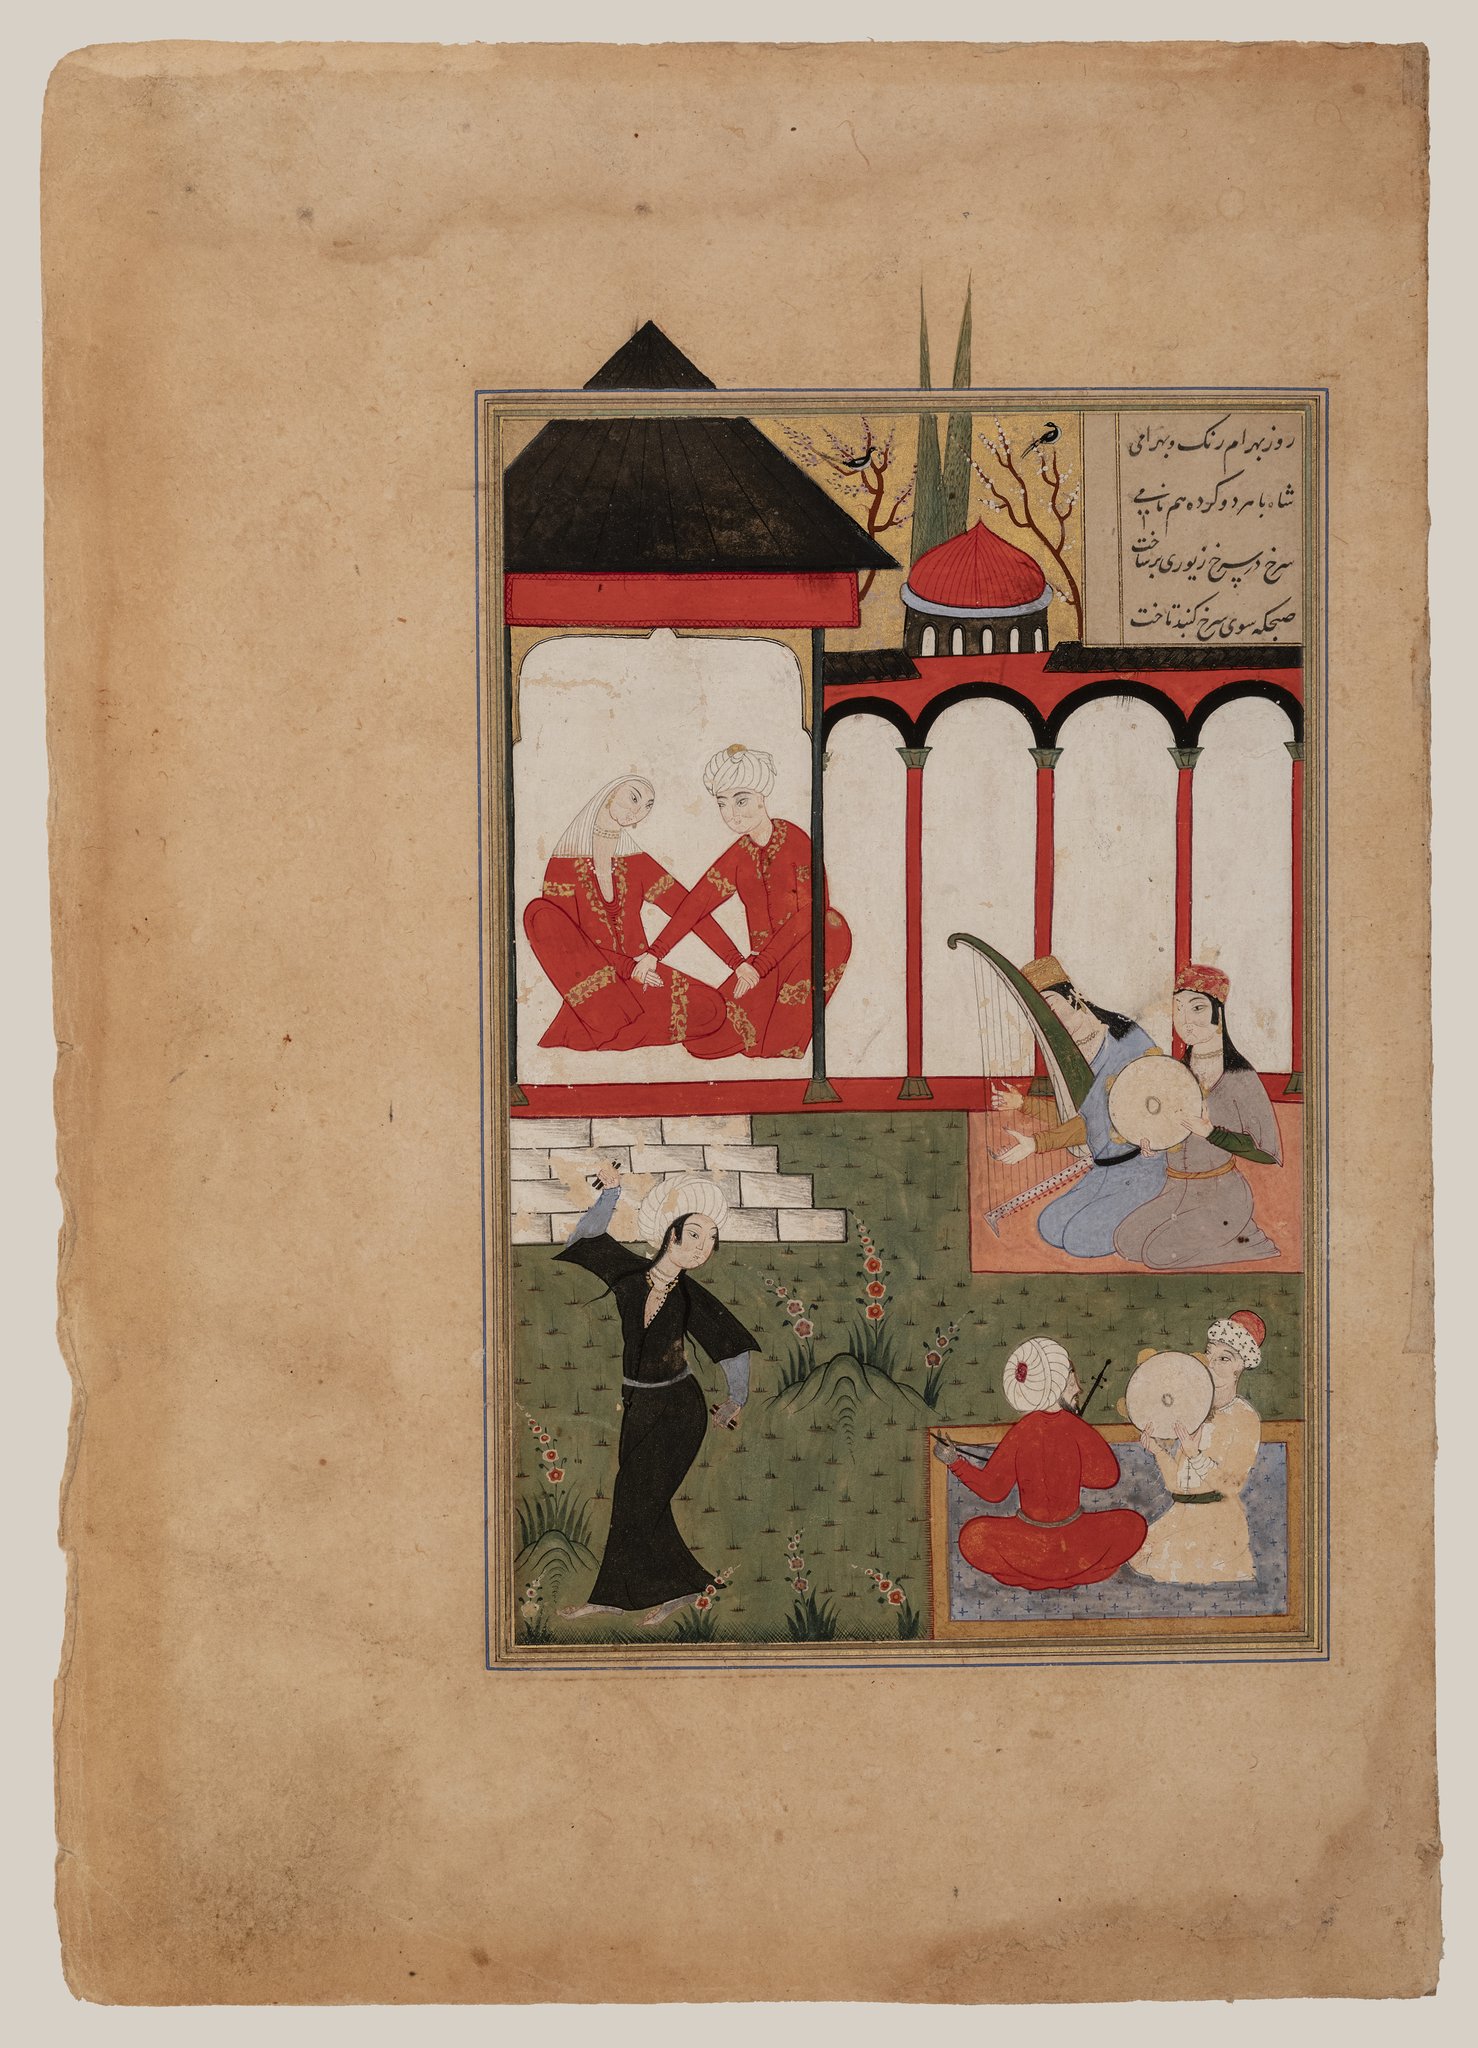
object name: folio from an illustrated manuscript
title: "Bahram Gur in the Red Pavilion", Folio from a Haft Paikar (Seven Portraits) of the Khamsa (Quintet) of Nizami of Ganja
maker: nizami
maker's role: author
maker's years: 1141-1209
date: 1520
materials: gold, ink, paper, silver, watercolor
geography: turkey